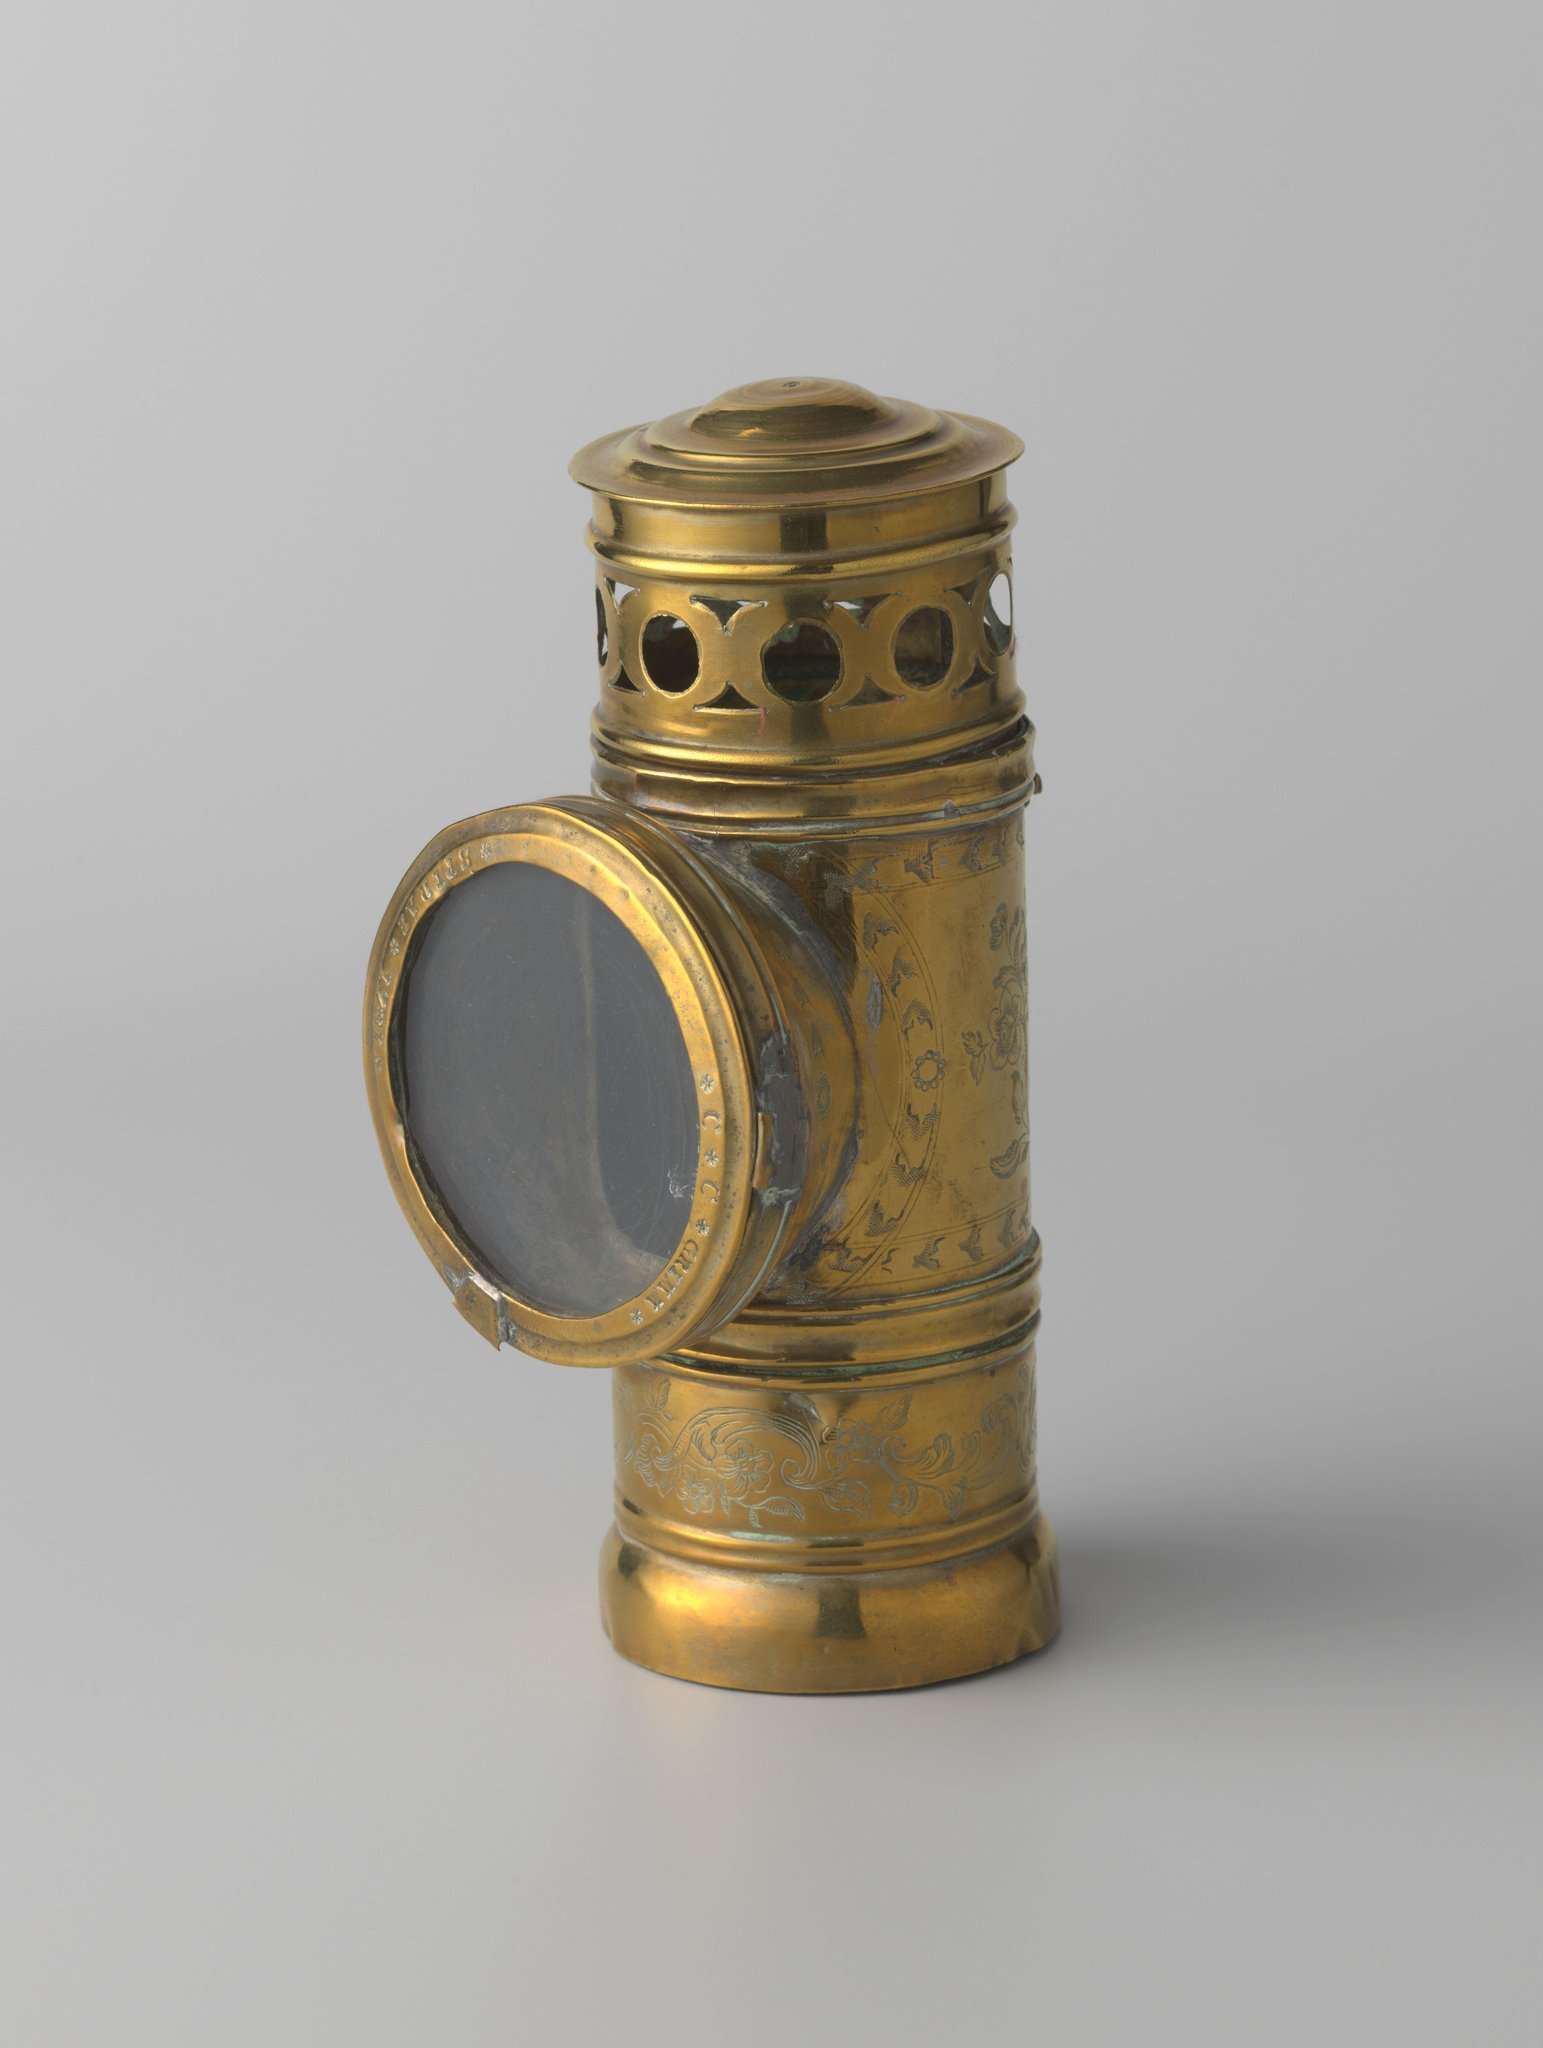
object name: lantern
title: Handlantaarn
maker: c.c. grimm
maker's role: koperslager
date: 1787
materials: brass, glass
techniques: embroidery, striking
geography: speyer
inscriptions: inscription: ‘CC GRIMM / SPIRAE 1787’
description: Het uit koperplaat gemaakte cylindervormige van gegraveerd rankenornament voorziene voorwerp, waarin een kaarsje kan worden geplaatst, heeft aan de voorkant een rond kleurloos glas en aan de achterkant een uitklapbaar handvat, dat nog slechts ten dele aanwezig is.